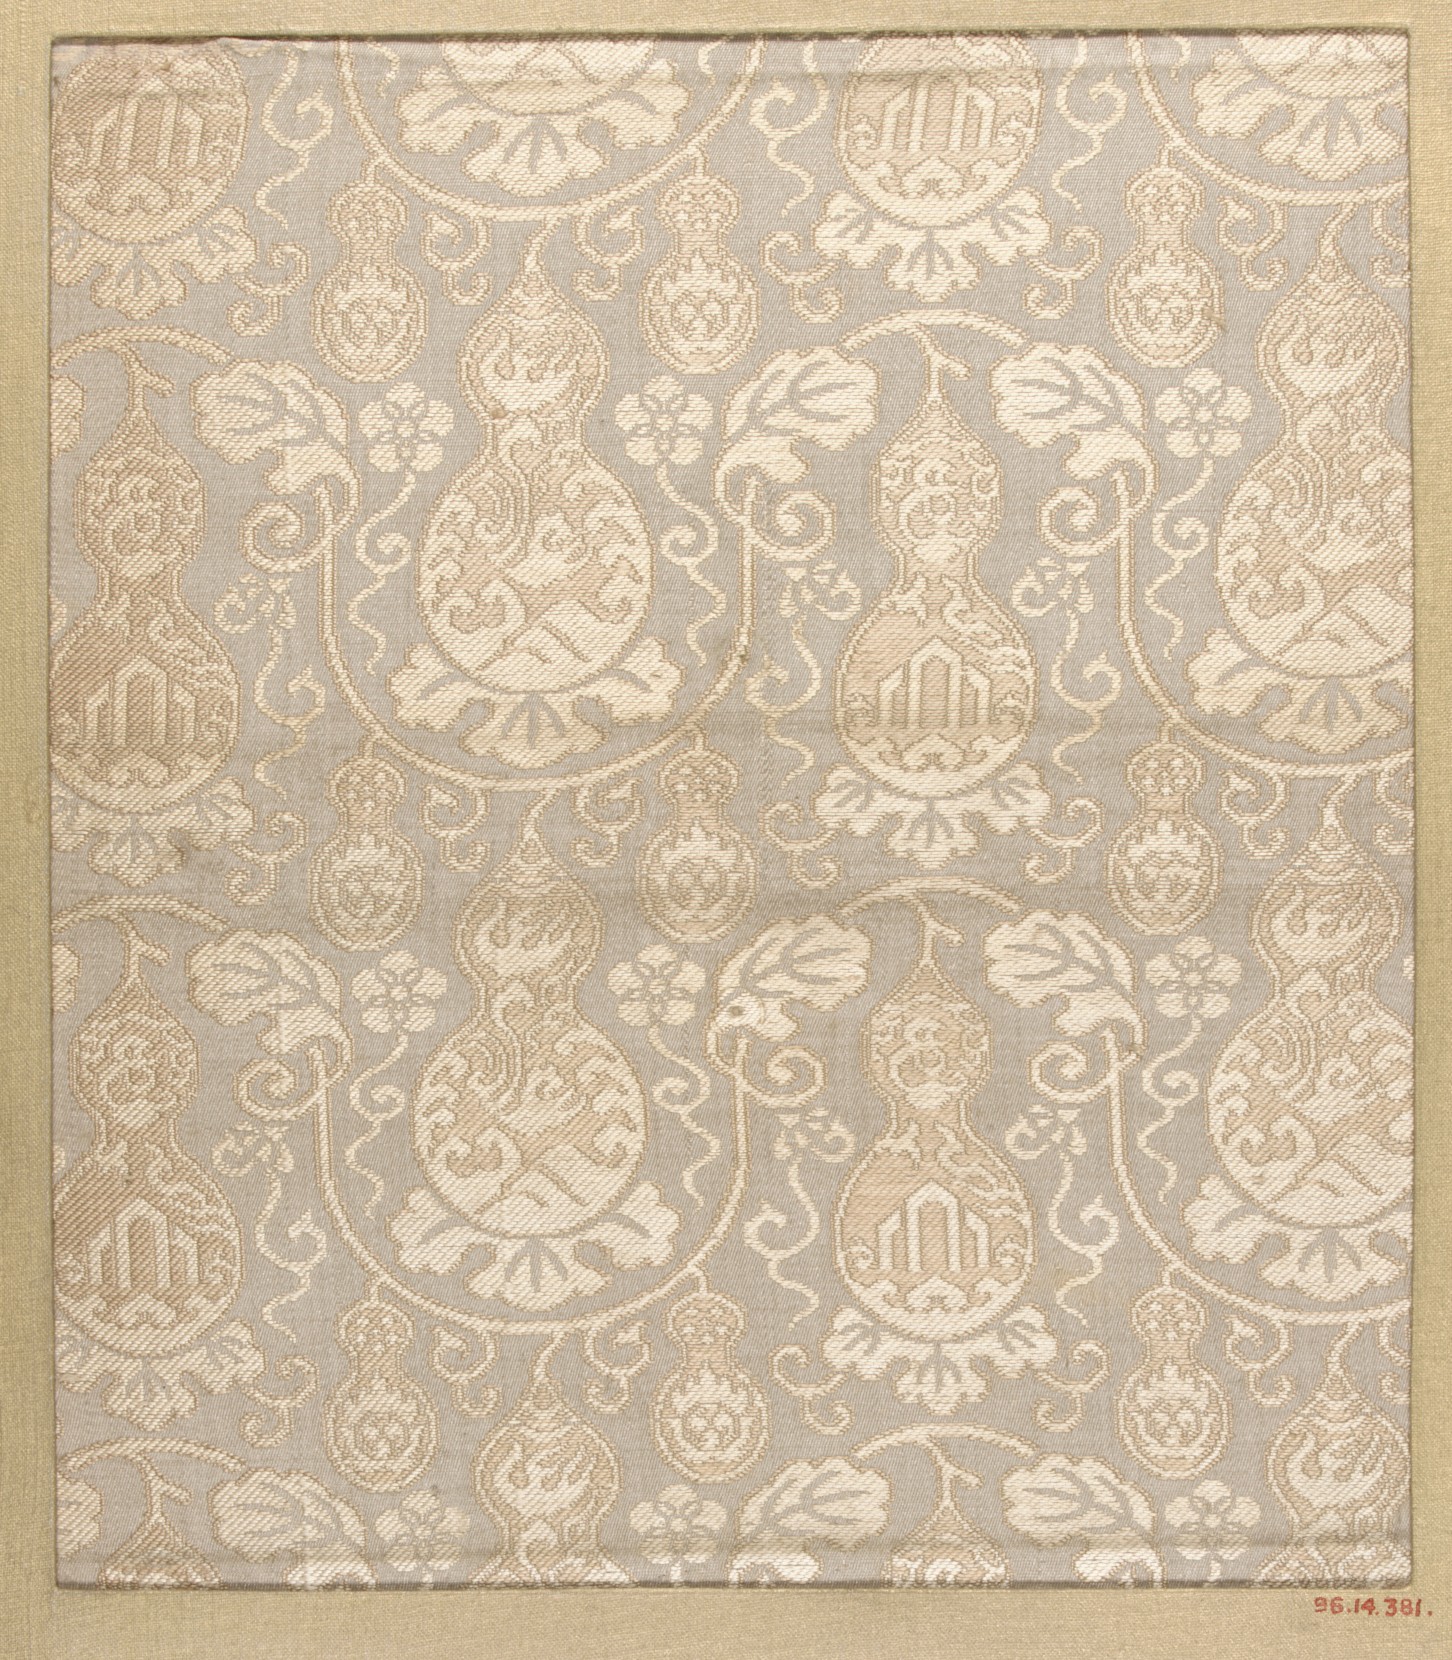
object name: piece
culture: japanese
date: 1701-1900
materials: silk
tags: flowers